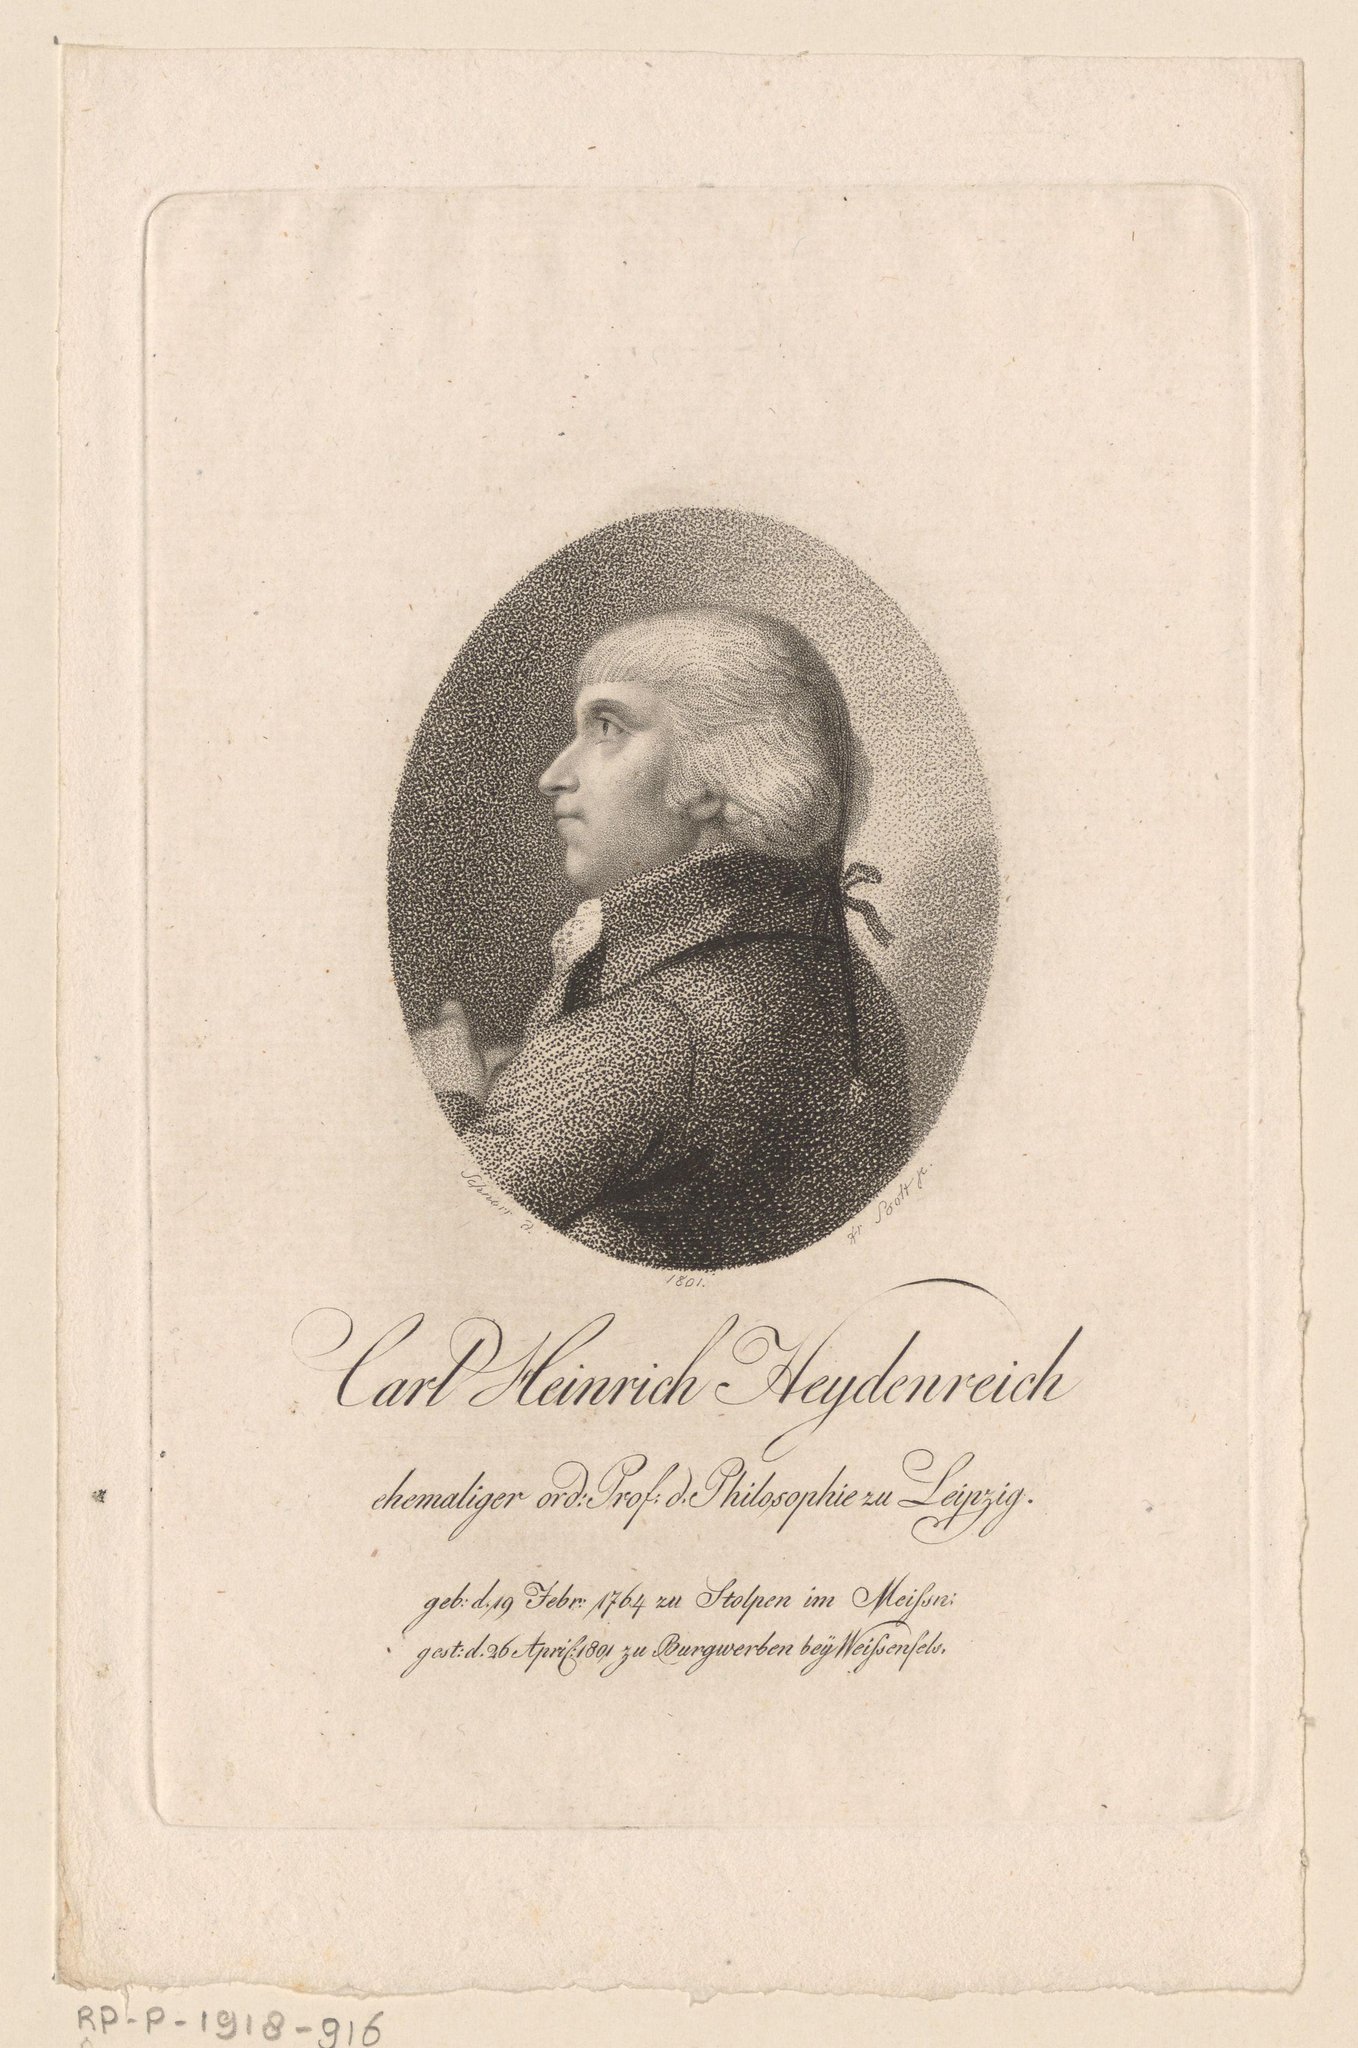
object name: print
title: Portret van Carl Heinrich Heydenreich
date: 1801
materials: paper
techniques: engraving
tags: historical persons, portrait of a writer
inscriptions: collector's mark: Lugt 2233